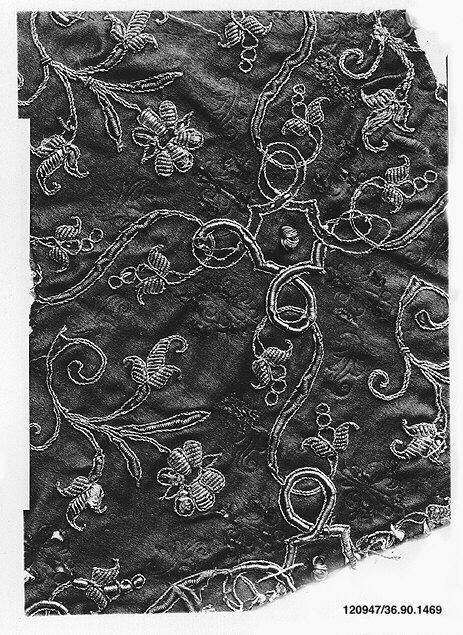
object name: piece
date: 1601-1700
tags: flowers